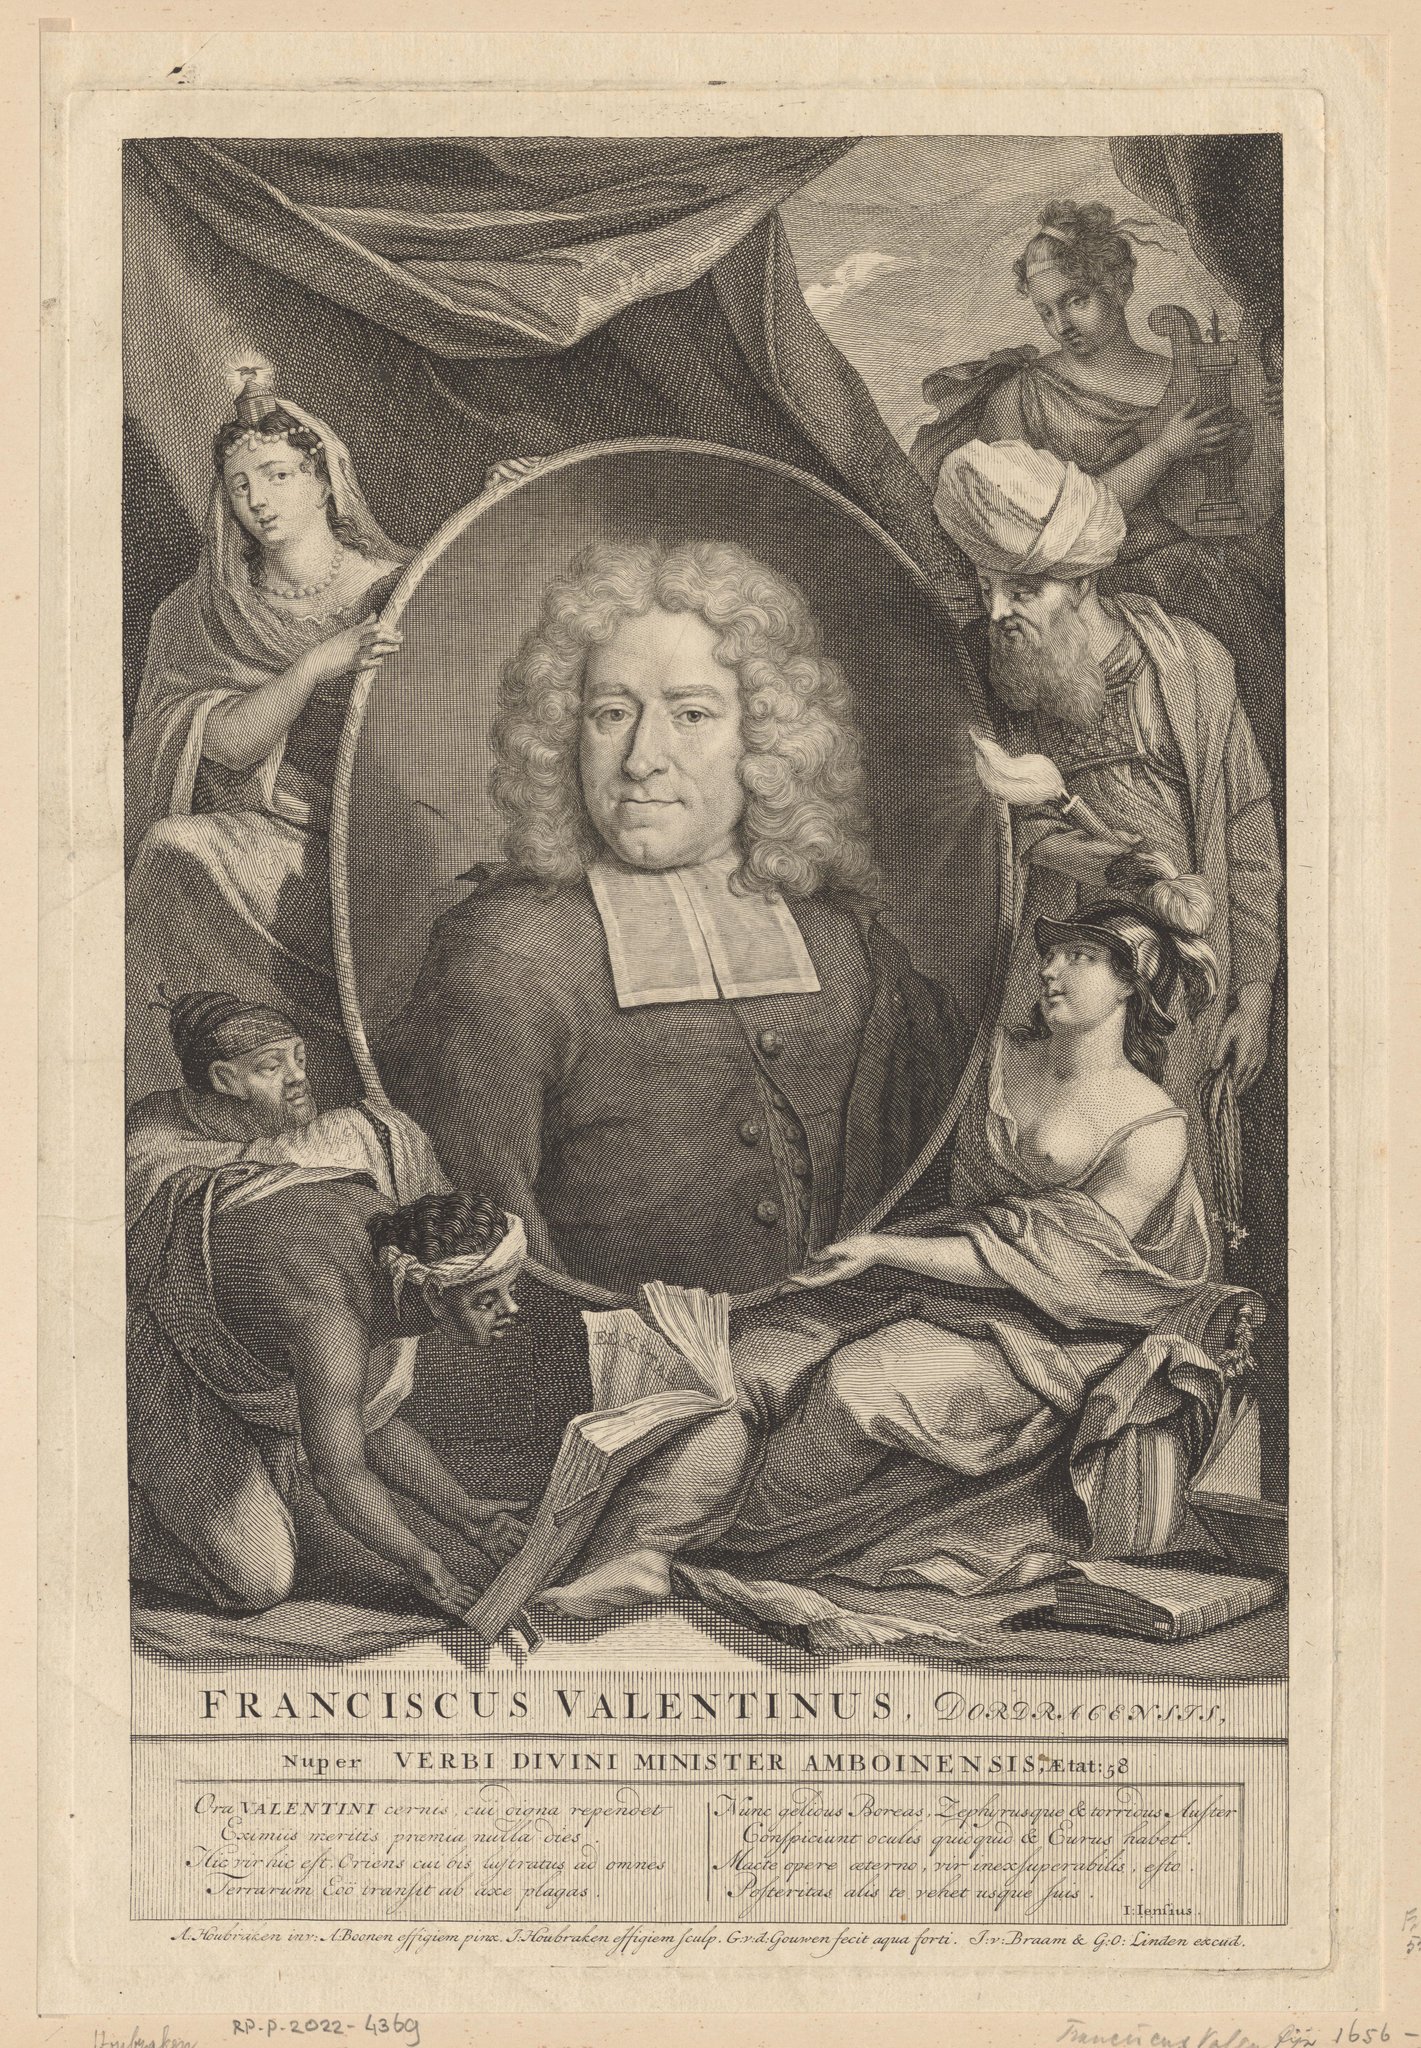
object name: print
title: Portret van François Valentijn op 58-jarige leeftijd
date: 1724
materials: paper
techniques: engraving, etching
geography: dordrecht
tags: the hague, fides (faith) as roman personification, asiatic races and peoples, minerva as patroness, torch, historical persons, harp, book, writer, poet, author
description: Onder het portret een achtregelig vers in het Latijn in twee kolommen.